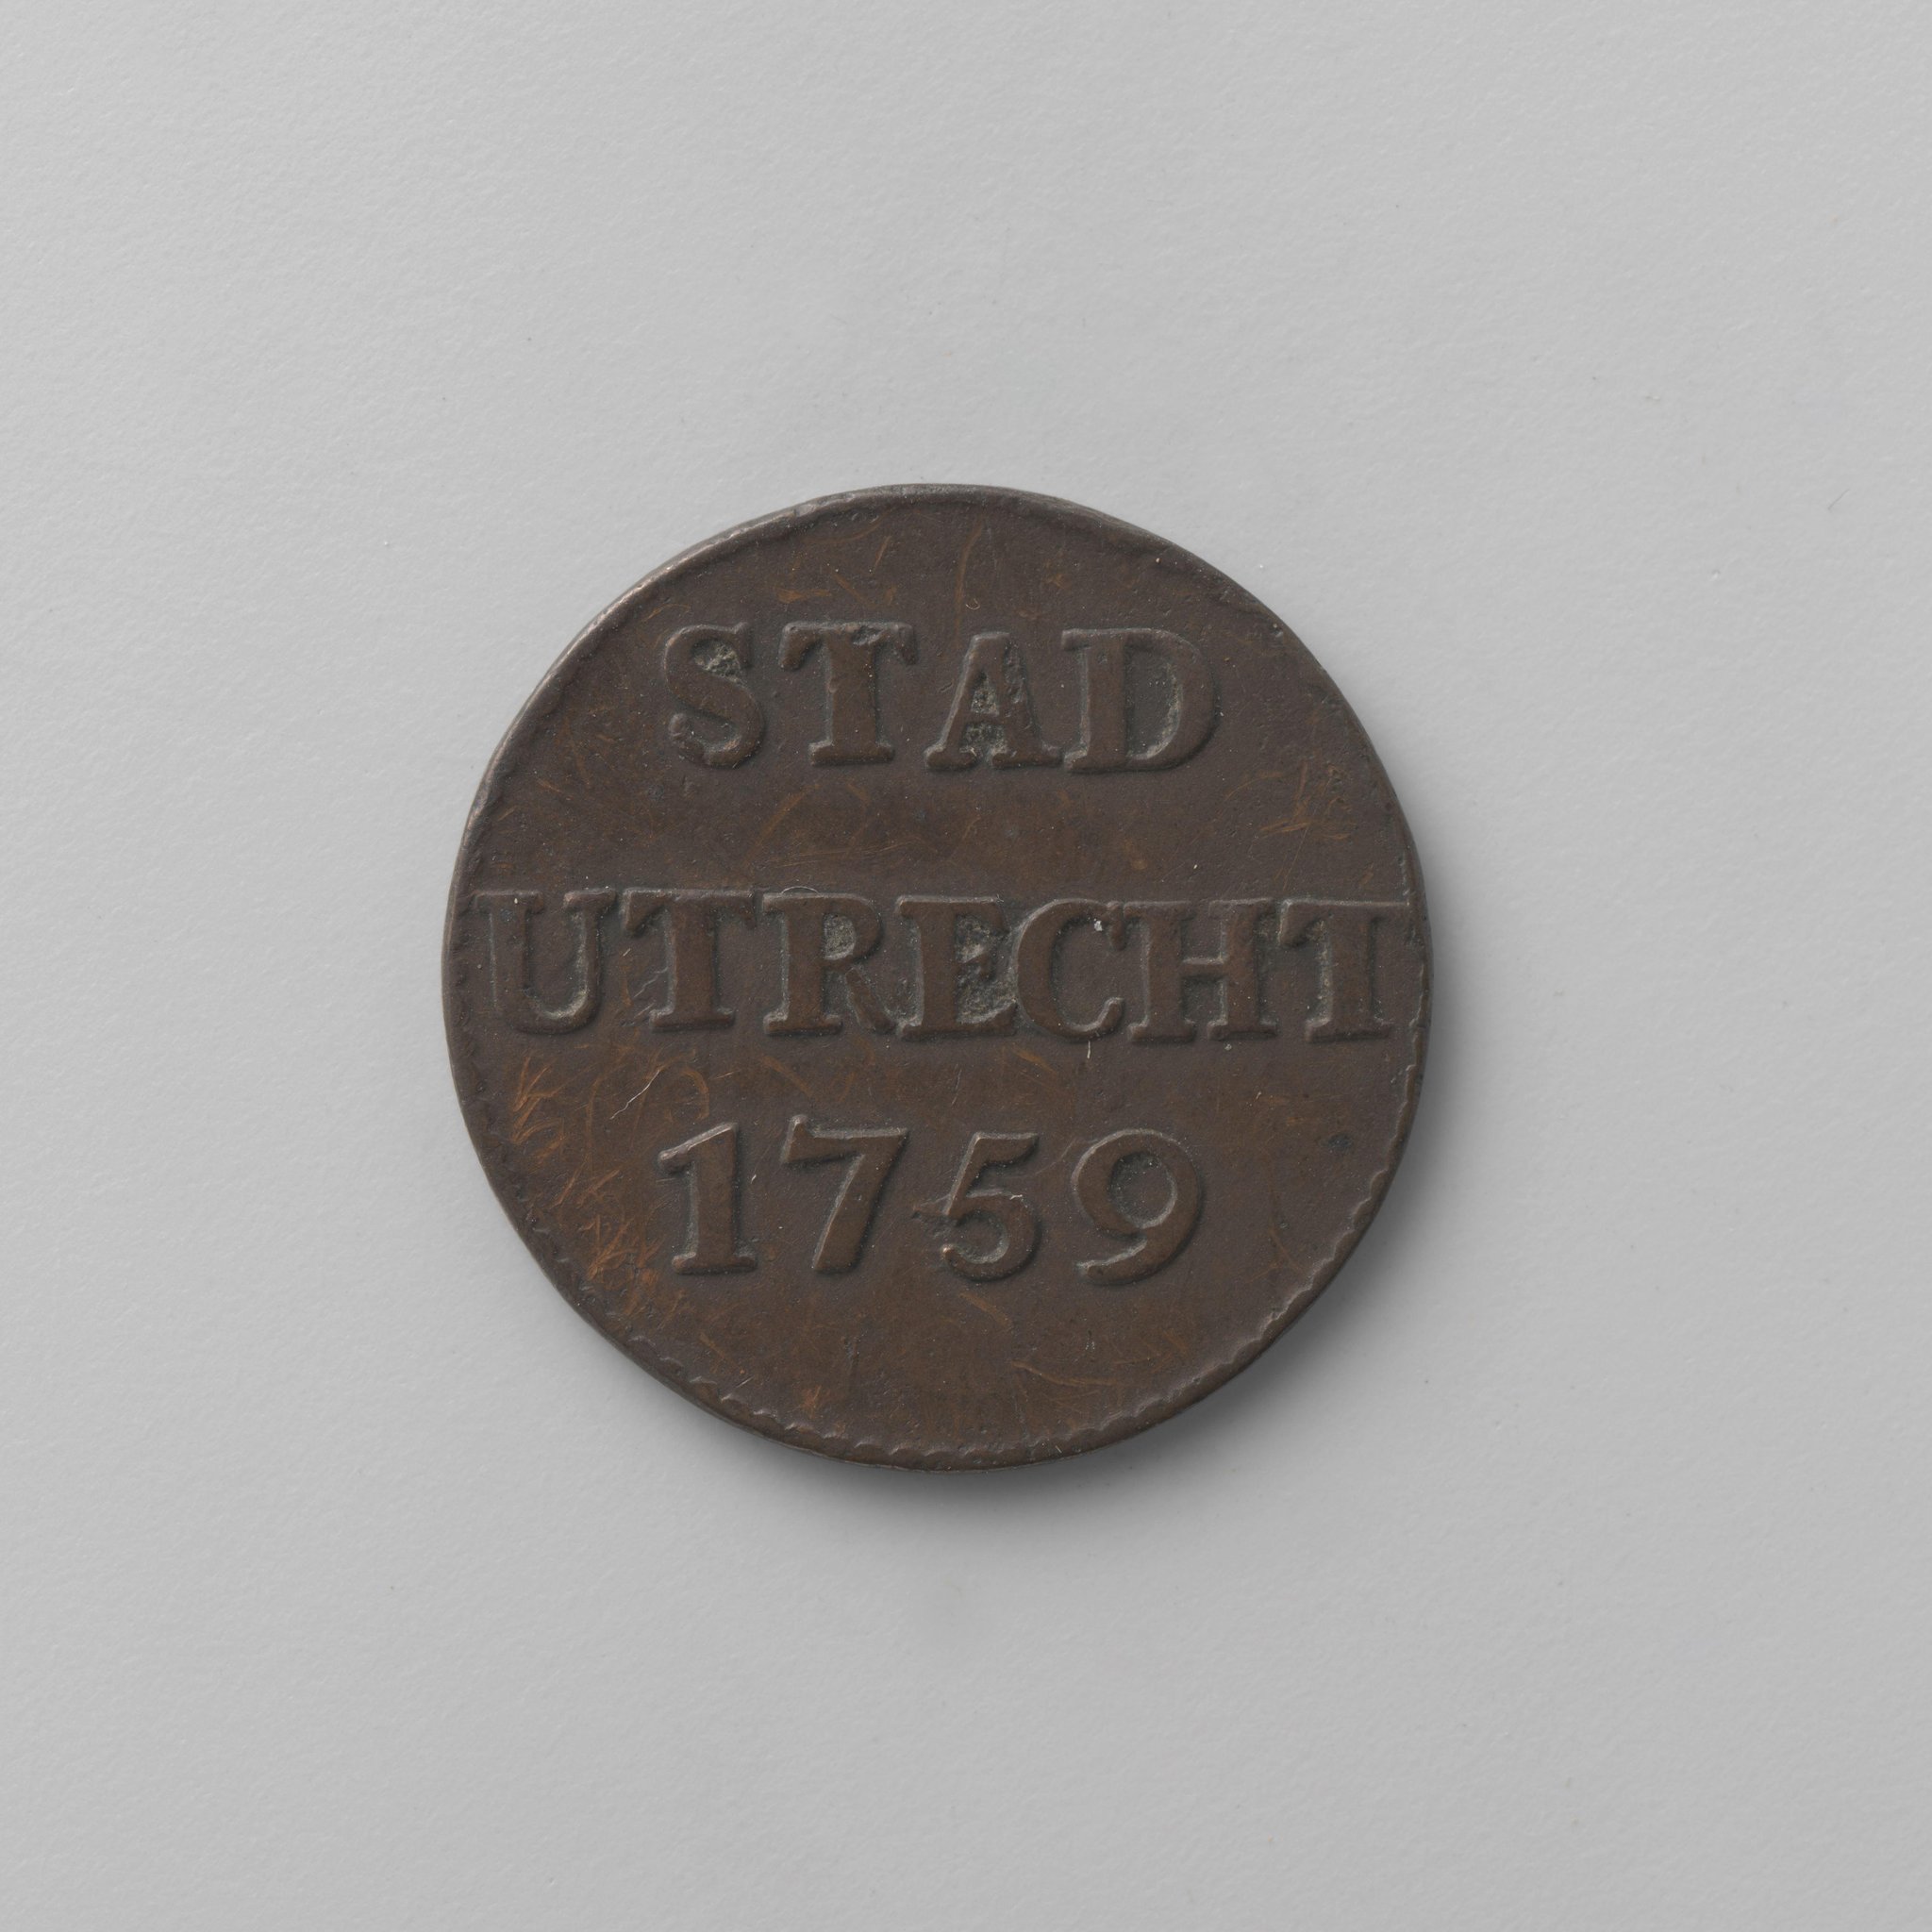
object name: coin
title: Stad Utrecht, duit, 1759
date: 1759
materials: copper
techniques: striking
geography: utrecht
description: Koperen munt. Voorzijde: gekroond stedelijk wapenschild, gehouden door twee leeuwen met in afsnede dunne lijn, waaronder een versierde accolade met een grote schelp. Keerzijde: opschrift in twee regels, waaronder jaartal. Jaartal met Arabische 1.